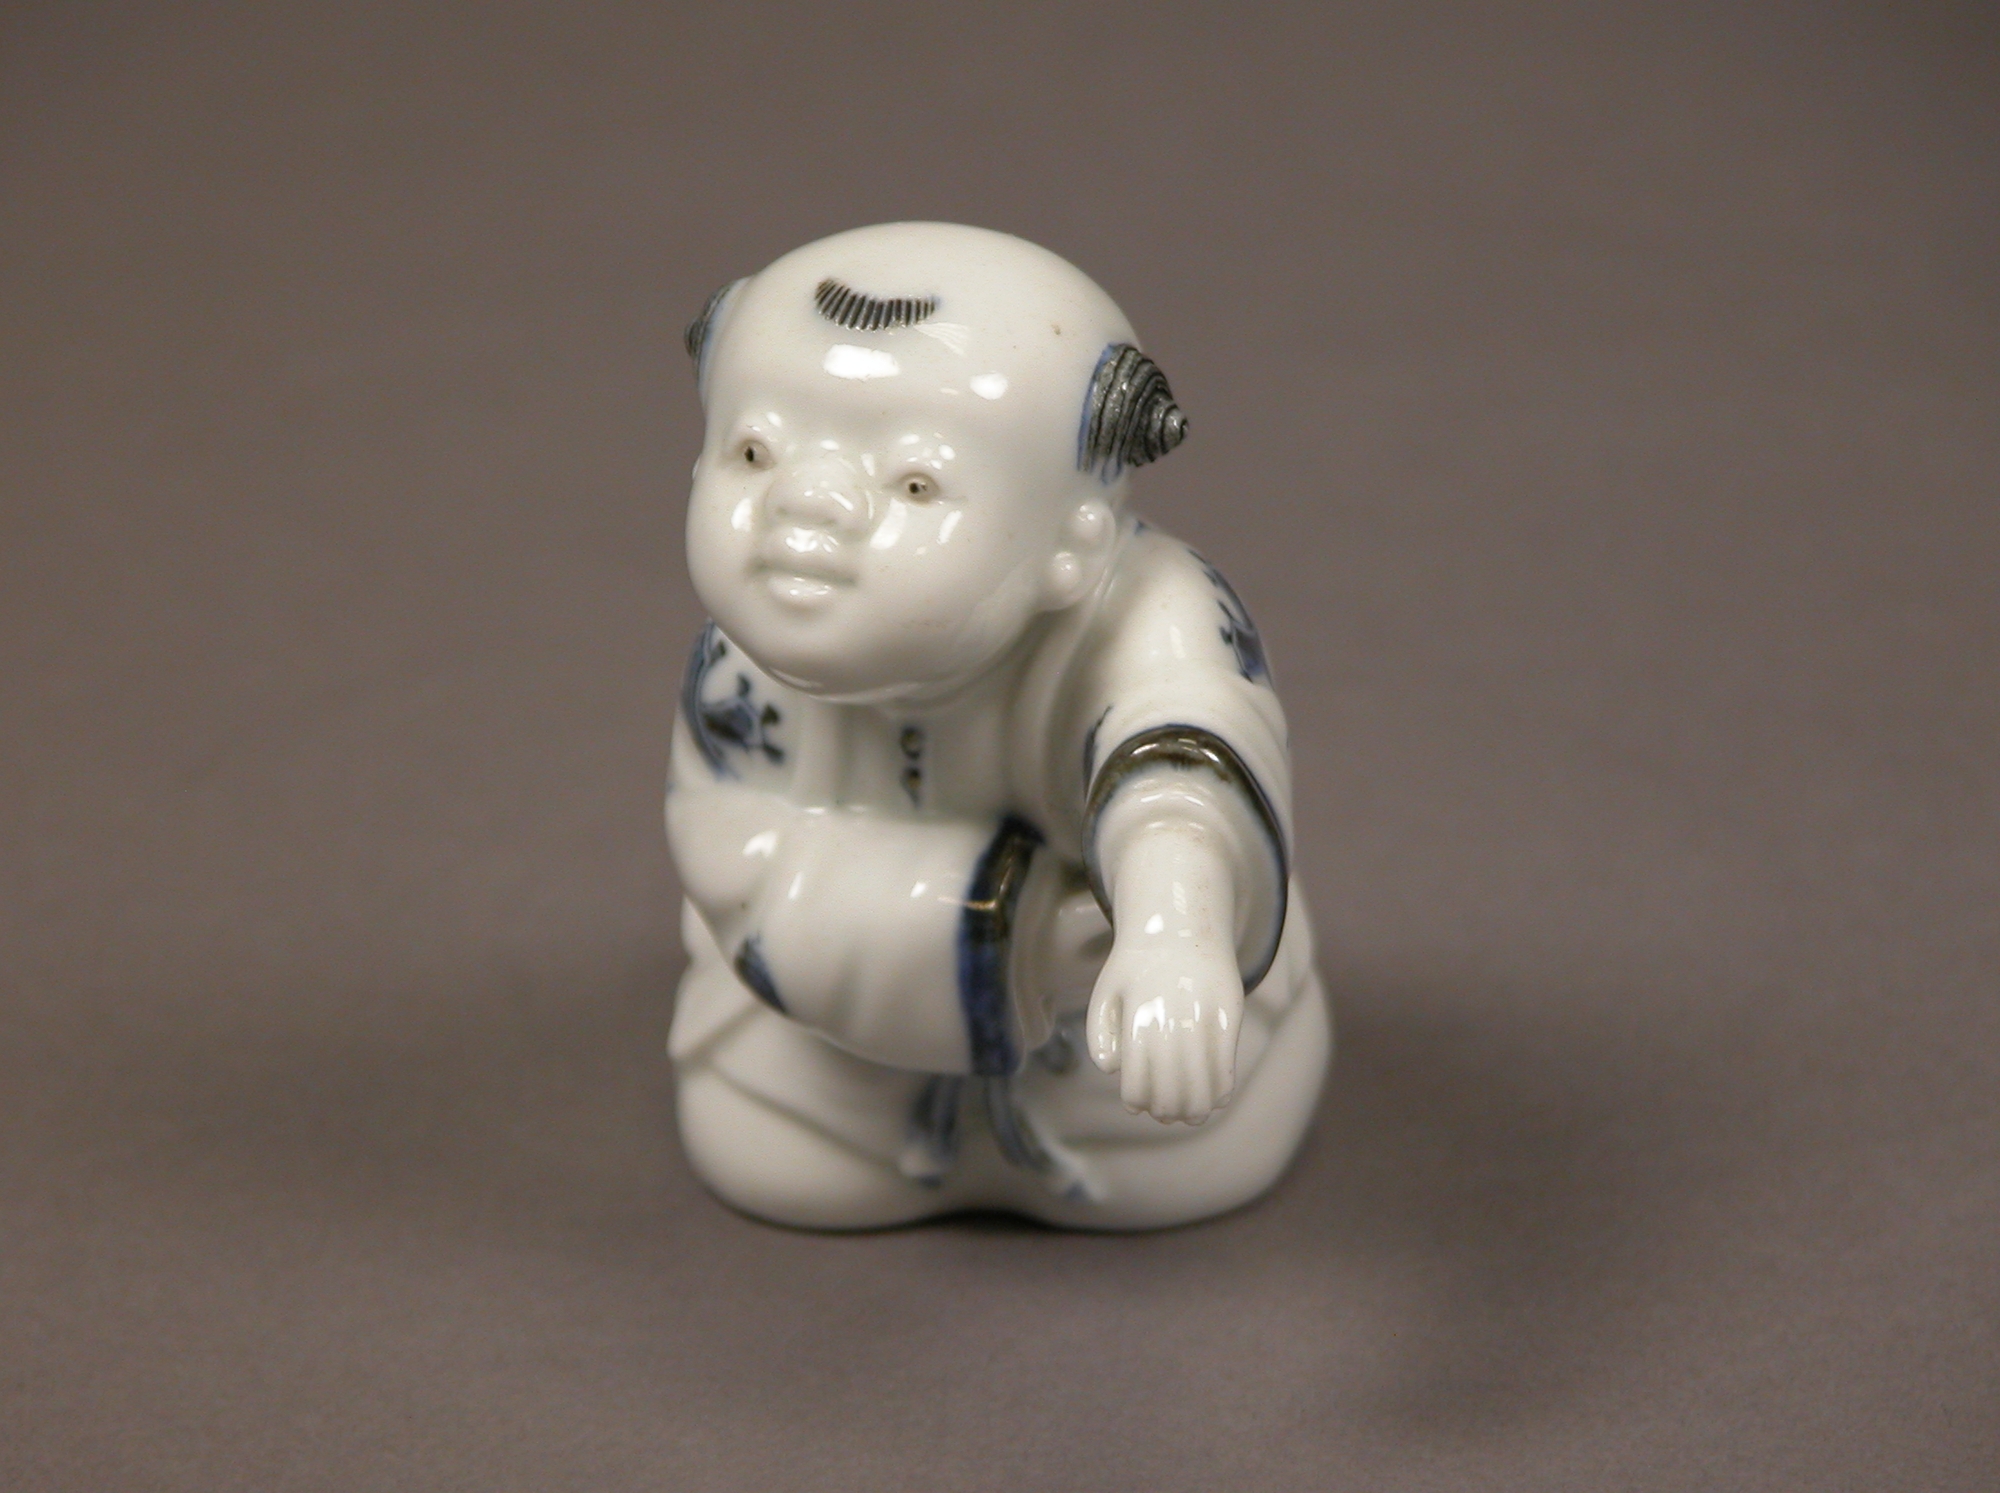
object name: ceramic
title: Chinese Child Playing a Game of Go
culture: japanese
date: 1767-1800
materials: porcelain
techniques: underglaze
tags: boys,playing,games